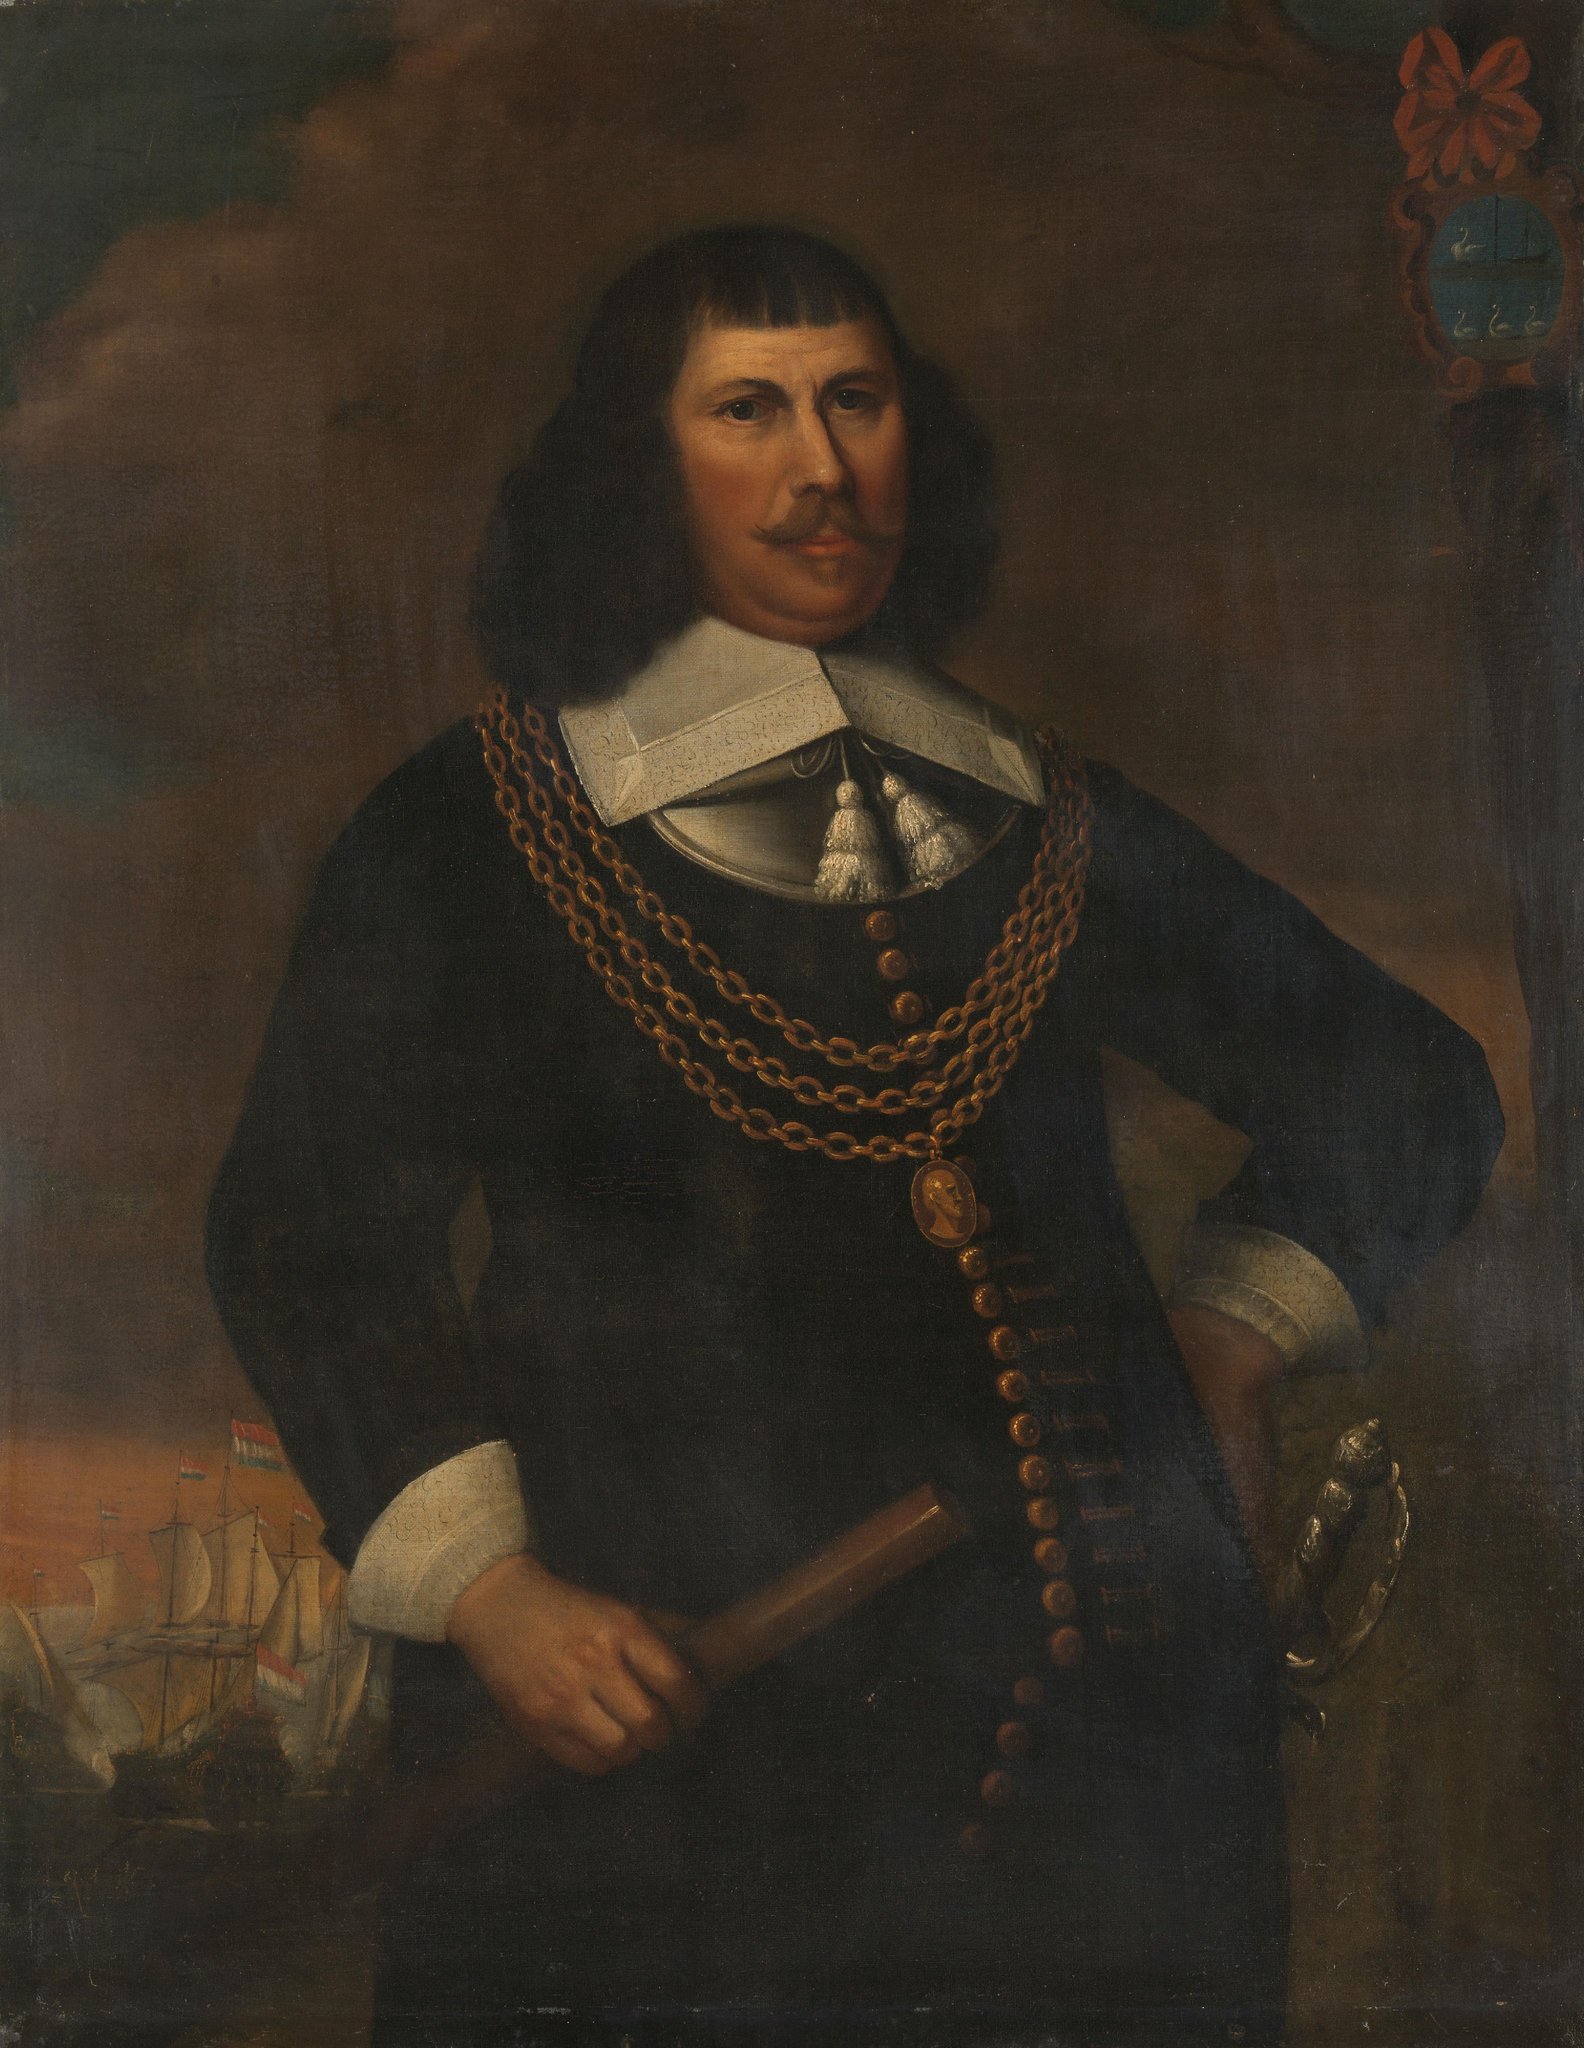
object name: painting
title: Pieter Florisz (ca. 1605-58), Vice-Admiral of the Northern District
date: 1650-1720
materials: canvas, oil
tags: historical persons, commander-in-chief, admiral, hoorn (north holland)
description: Portret van Pieter Florisse, vice-admiraal van het Noorderkwartier. Staand, kniestuk, commandostaf in de rechterhand, linkerhand in de zij. Op de achtergrond links een zeeslag. Rechtsboven het familiewapen.